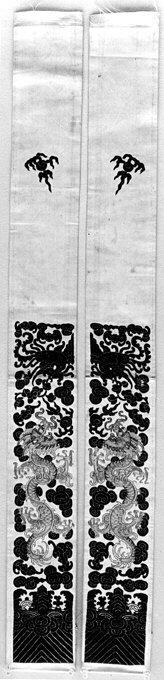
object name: sleeve band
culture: chinese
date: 1801-1900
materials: metal thread, silk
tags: dragons